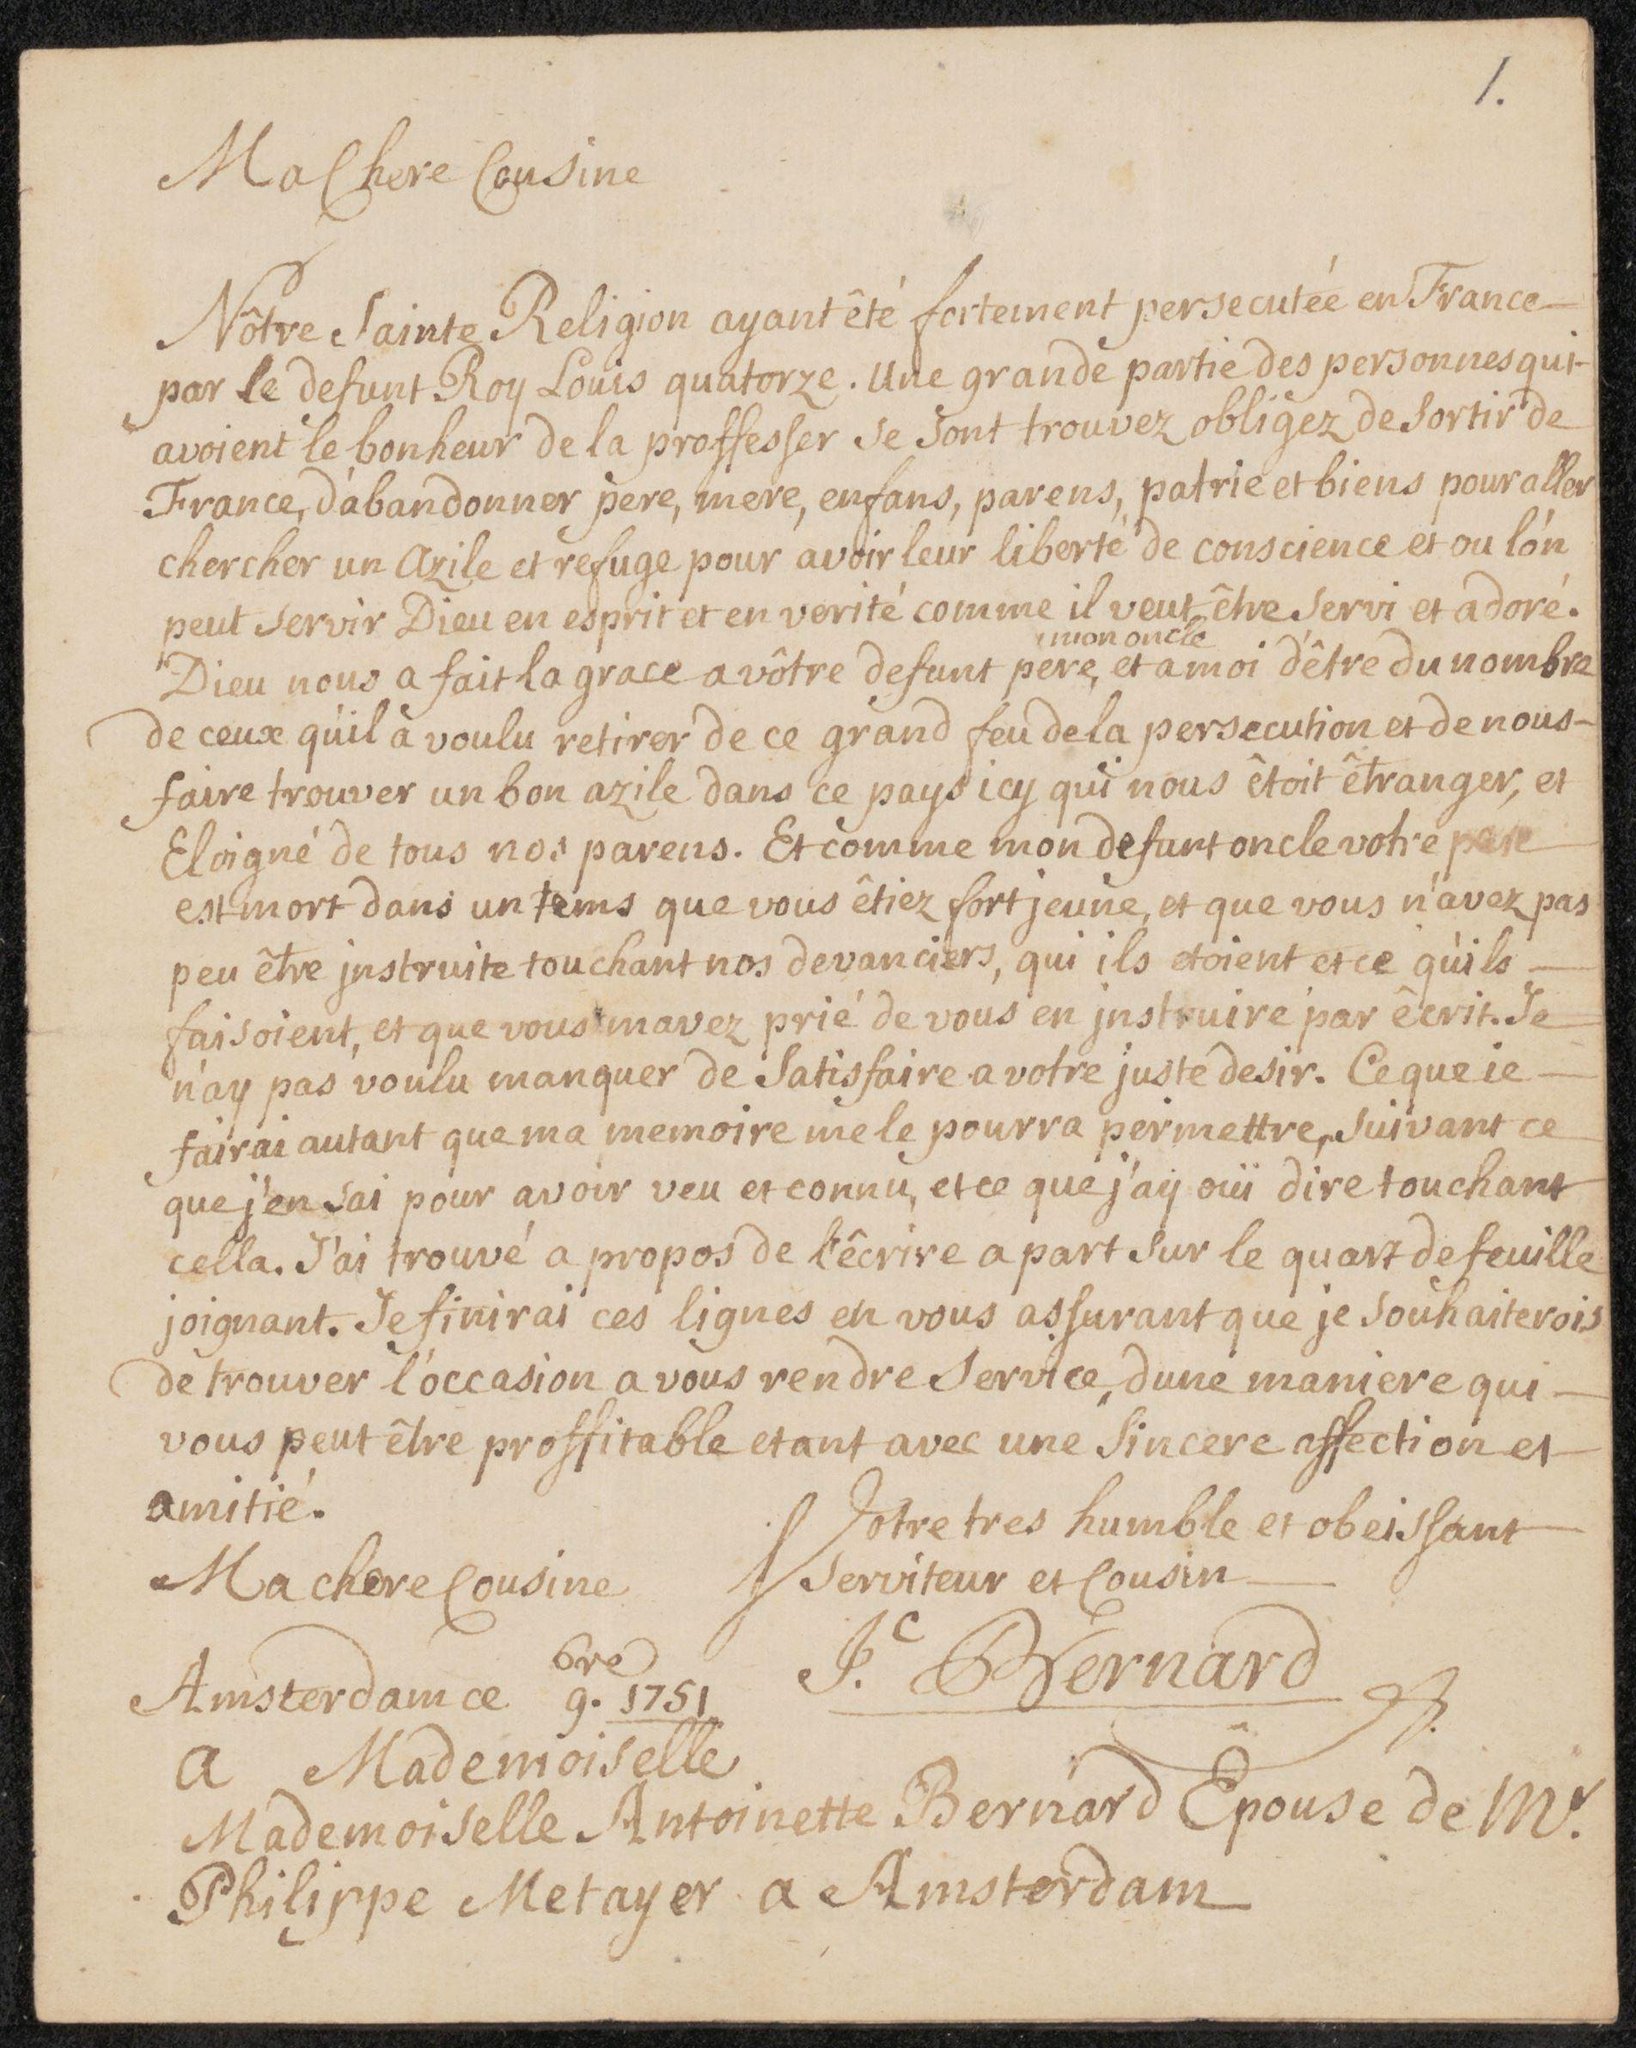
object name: letter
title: Brief aan Antoinette Bernard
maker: jean bernard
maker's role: draughtsman, print maker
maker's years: 1765-1833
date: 1711-1751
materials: ink, paper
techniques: pen, writing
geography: amsterdam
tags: antoinette bernard, lodewijk xiv (koning van frankrijk), family life, christian religion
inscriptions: collector's mark: Lugt 2233